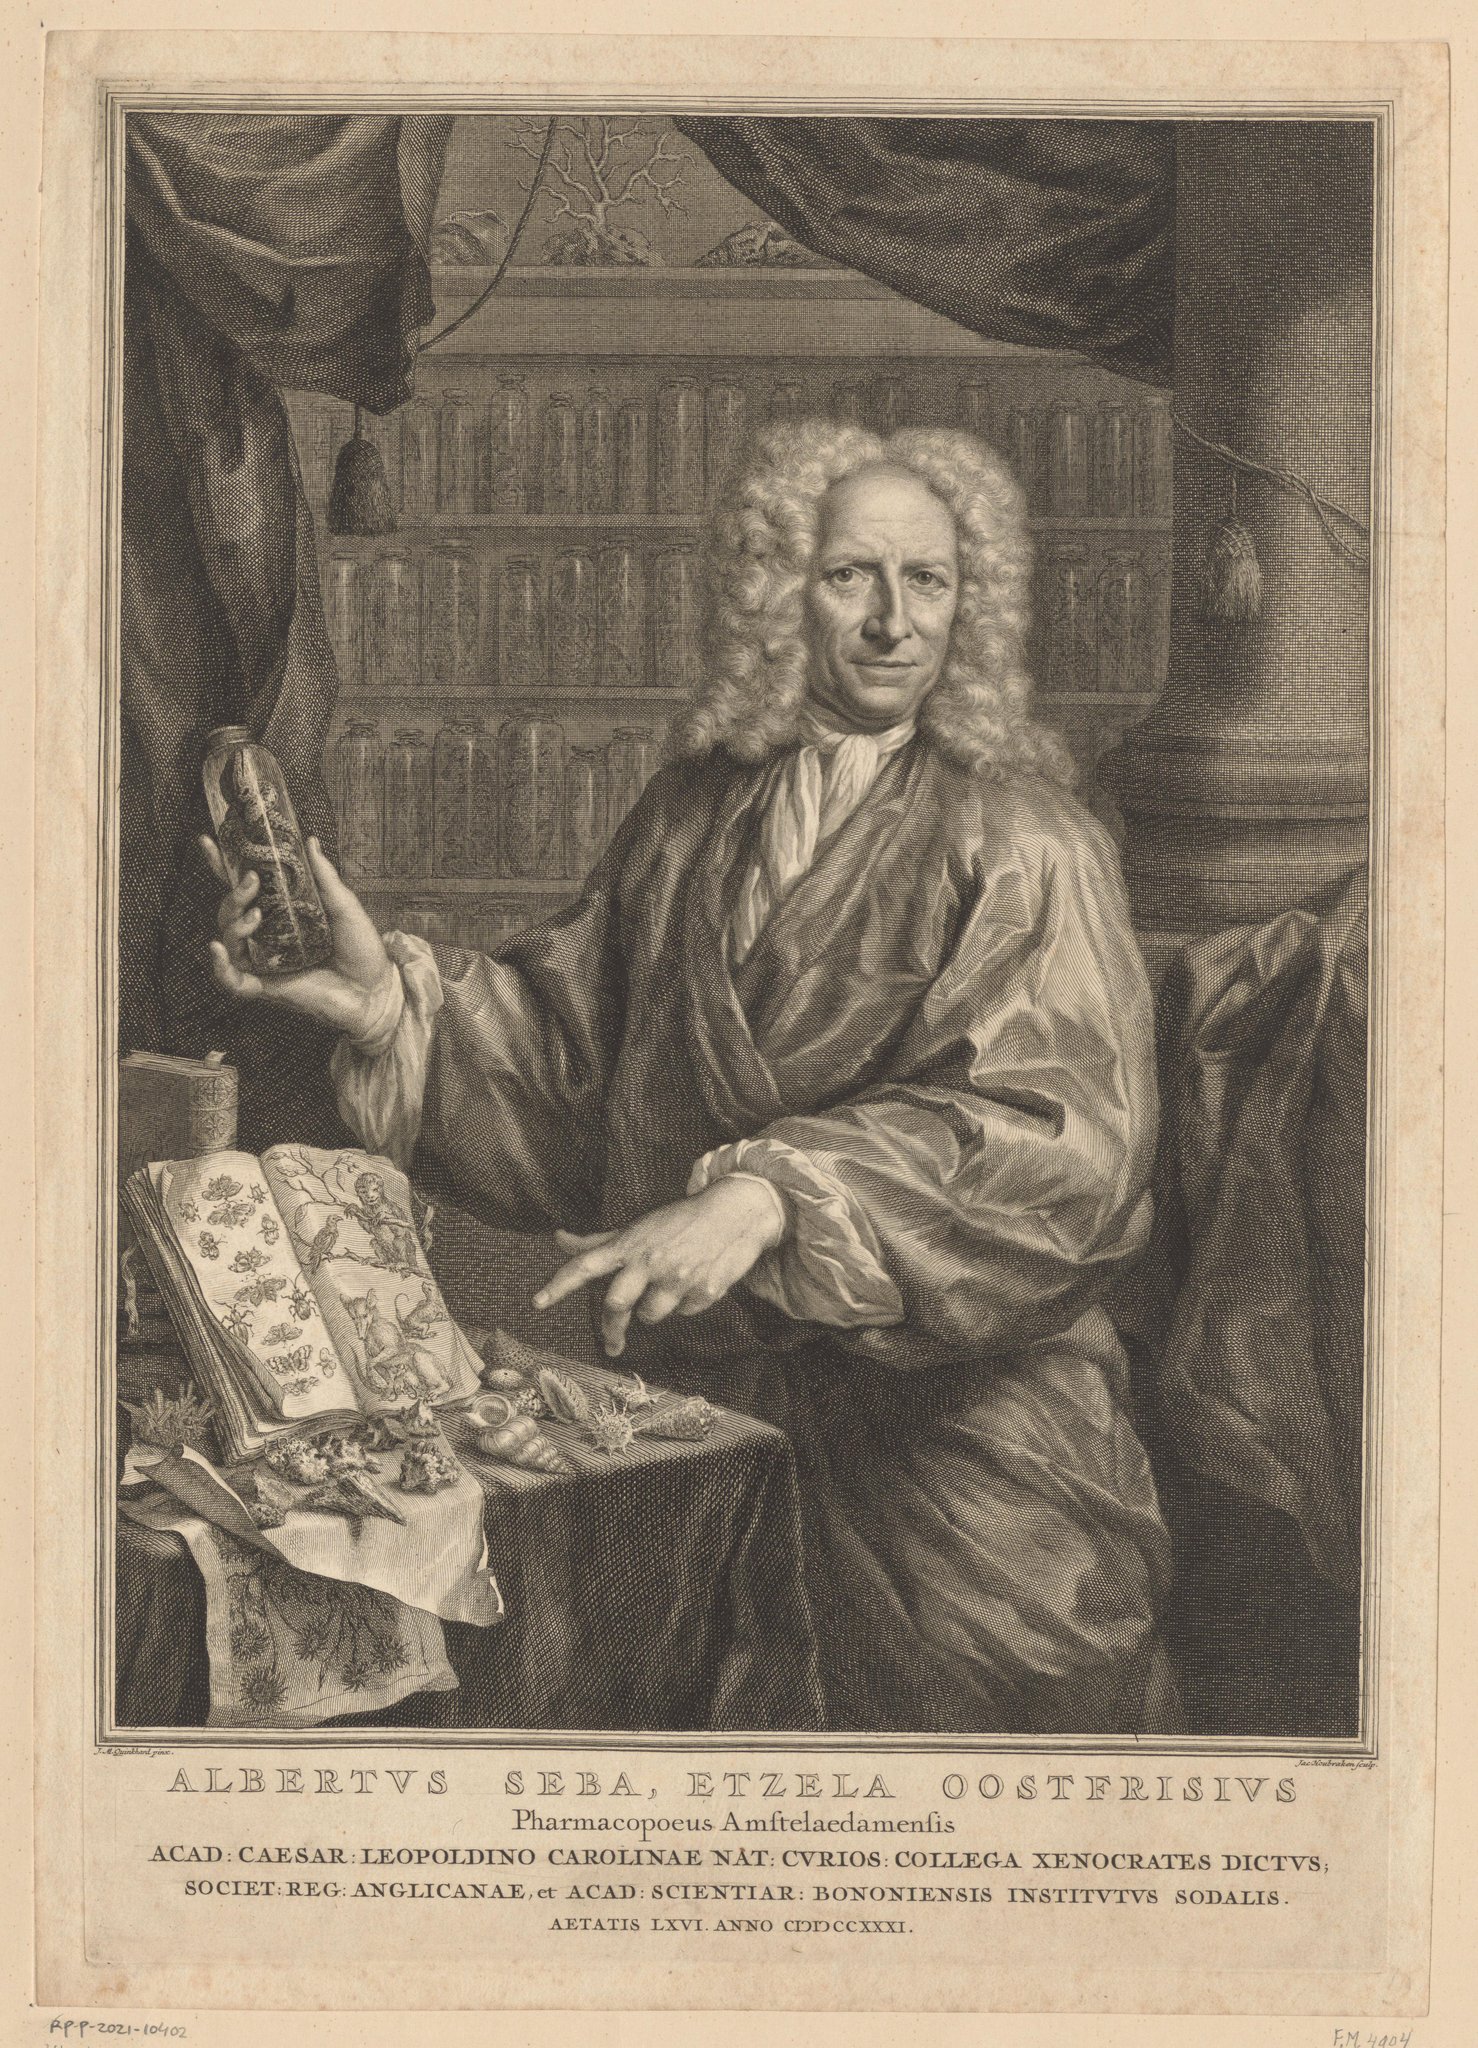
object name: print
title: Portret van Albertus Seba op 66-jarige leeftijd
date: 1731-1780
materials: paper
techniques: engraving, etching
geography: amsterdam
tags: amsterdam, albertus seba, snakes, historical persons, cabinet of curiosities, 'kunst- und wunderkammer'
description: Kniestuk van Albertus Seba op 66-jarige leeftijd, in zijn hand een glazen fles met daarin een slang. Hij staat bij een tafel waarop schelpen, vellen papier en een boek dat is opengeslagen met afbeeldingen van vlinders en andere dieren. Op de achtergrond een kast met glazen flessen met dieren.